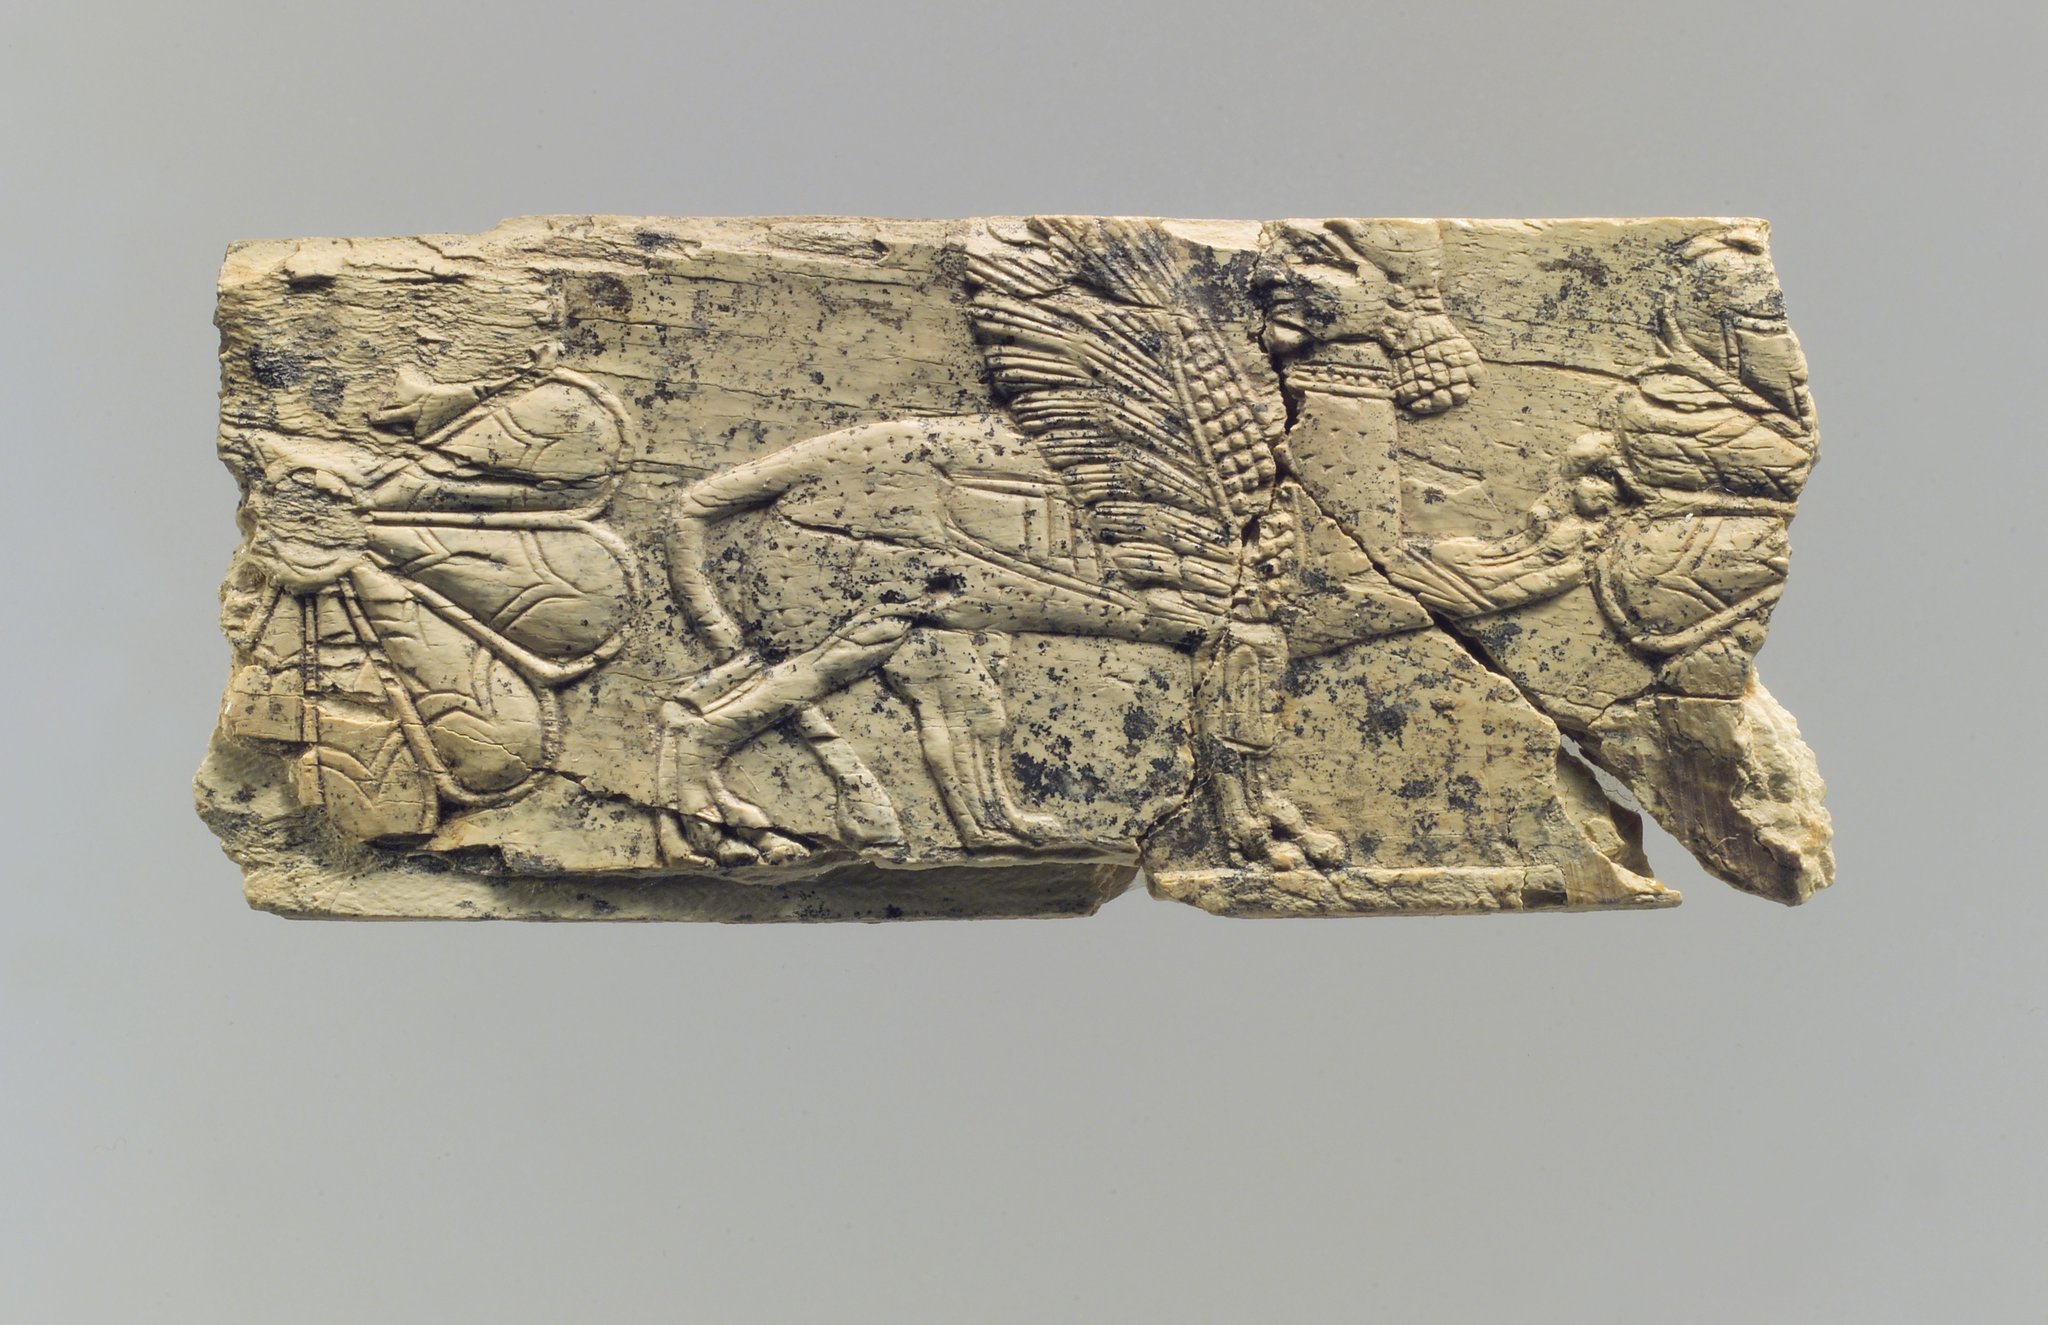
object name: relief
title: Panel fragment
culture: iranian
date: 800-601 BCE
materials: ivory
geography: iran